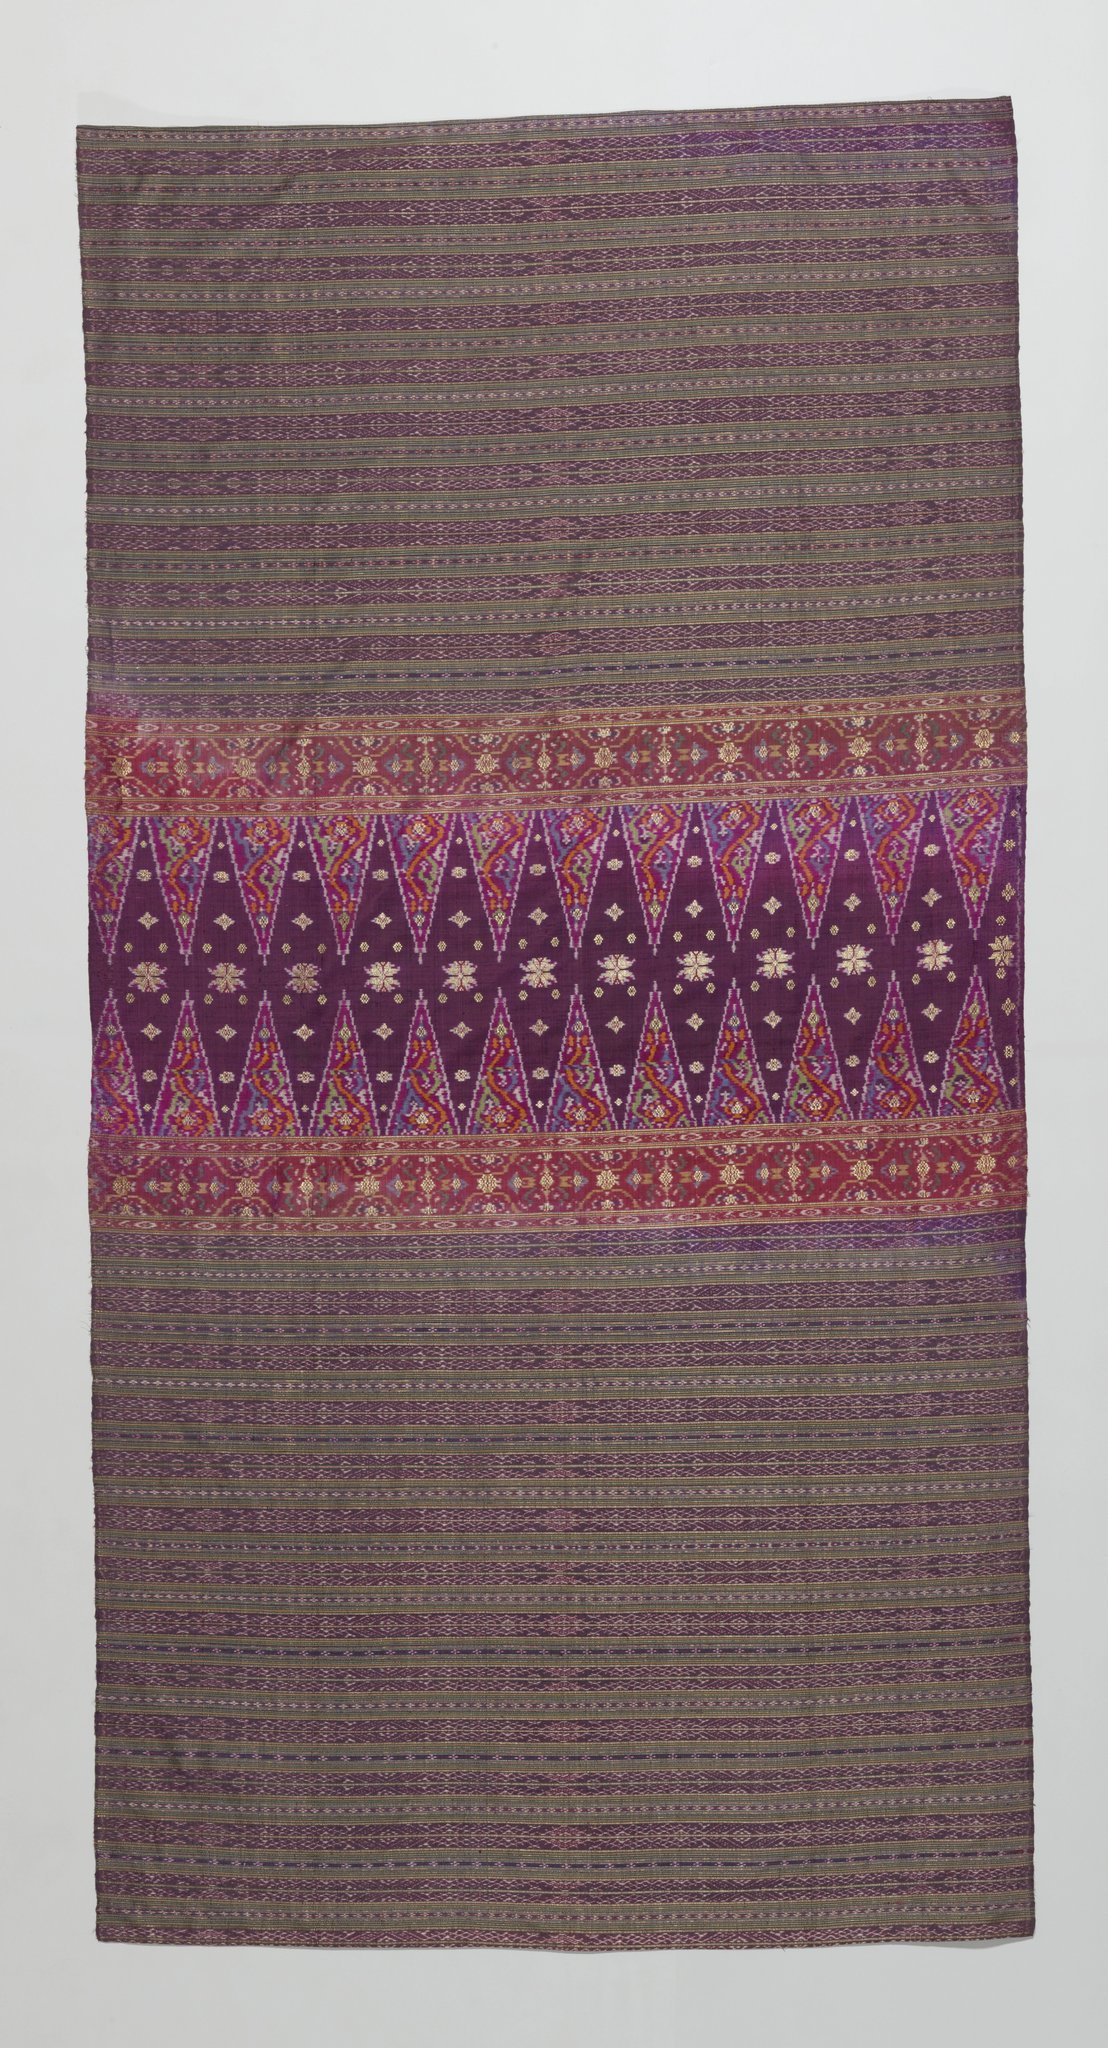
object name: heupdoek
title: Hip cloth (Sarong)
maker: Anonymous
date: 1900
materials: gold thread, silk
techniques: weave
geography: malaysia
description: This hip cloth is decorated by means of a method called ‘songket’. During the weaving process, gold or silver threads are added to the silk by hand, creating a raised, shiny surface. The cloth was wrapped around the hips, with the bright colours as a vertical panel at the front.